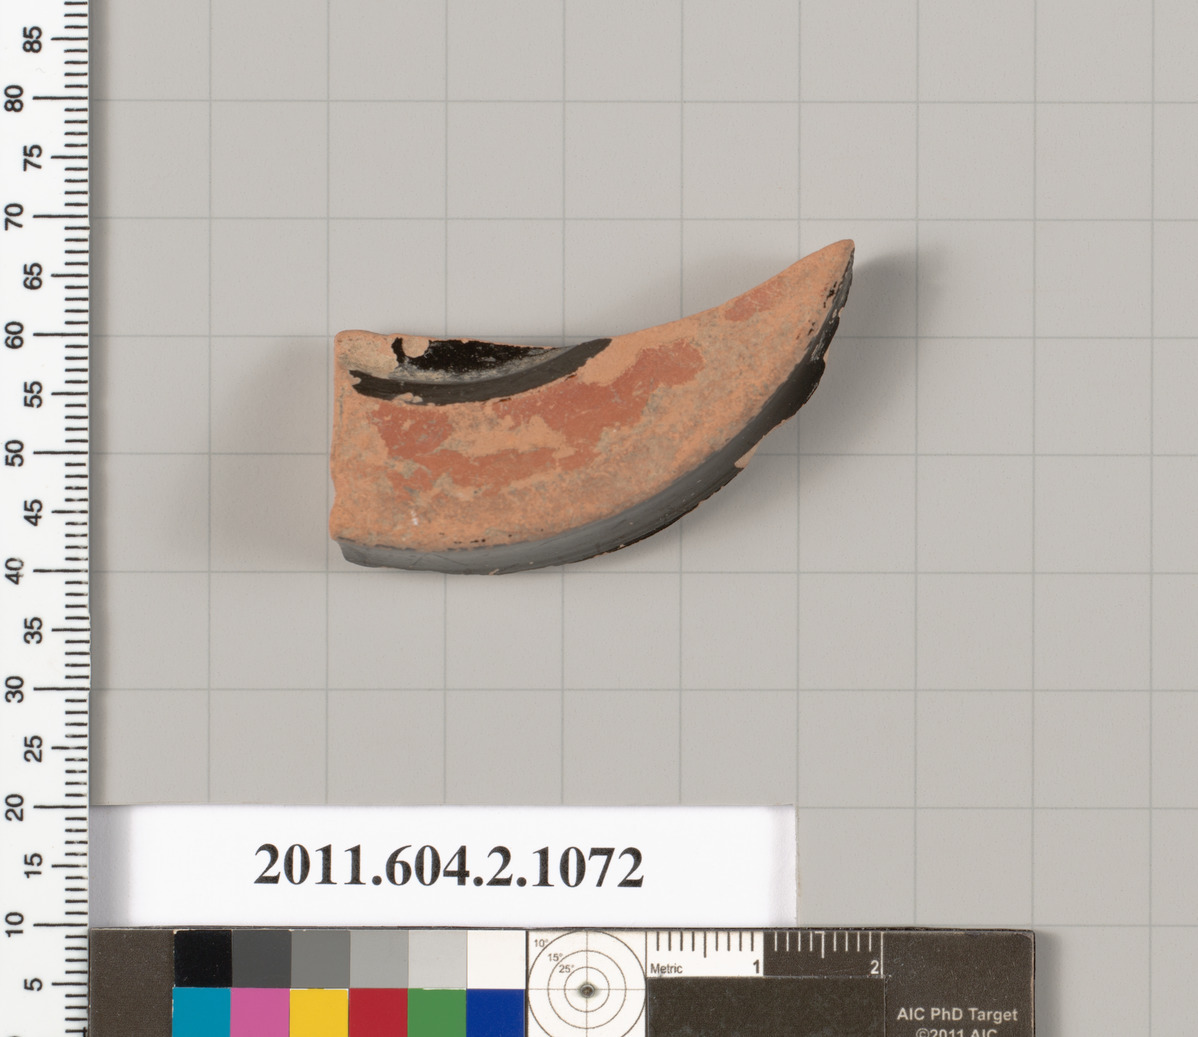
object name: oinochoe fragment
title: Terracotta fragment of an oinochoe (jug)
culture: greek, attic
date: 500-401 BCE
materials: terracotta